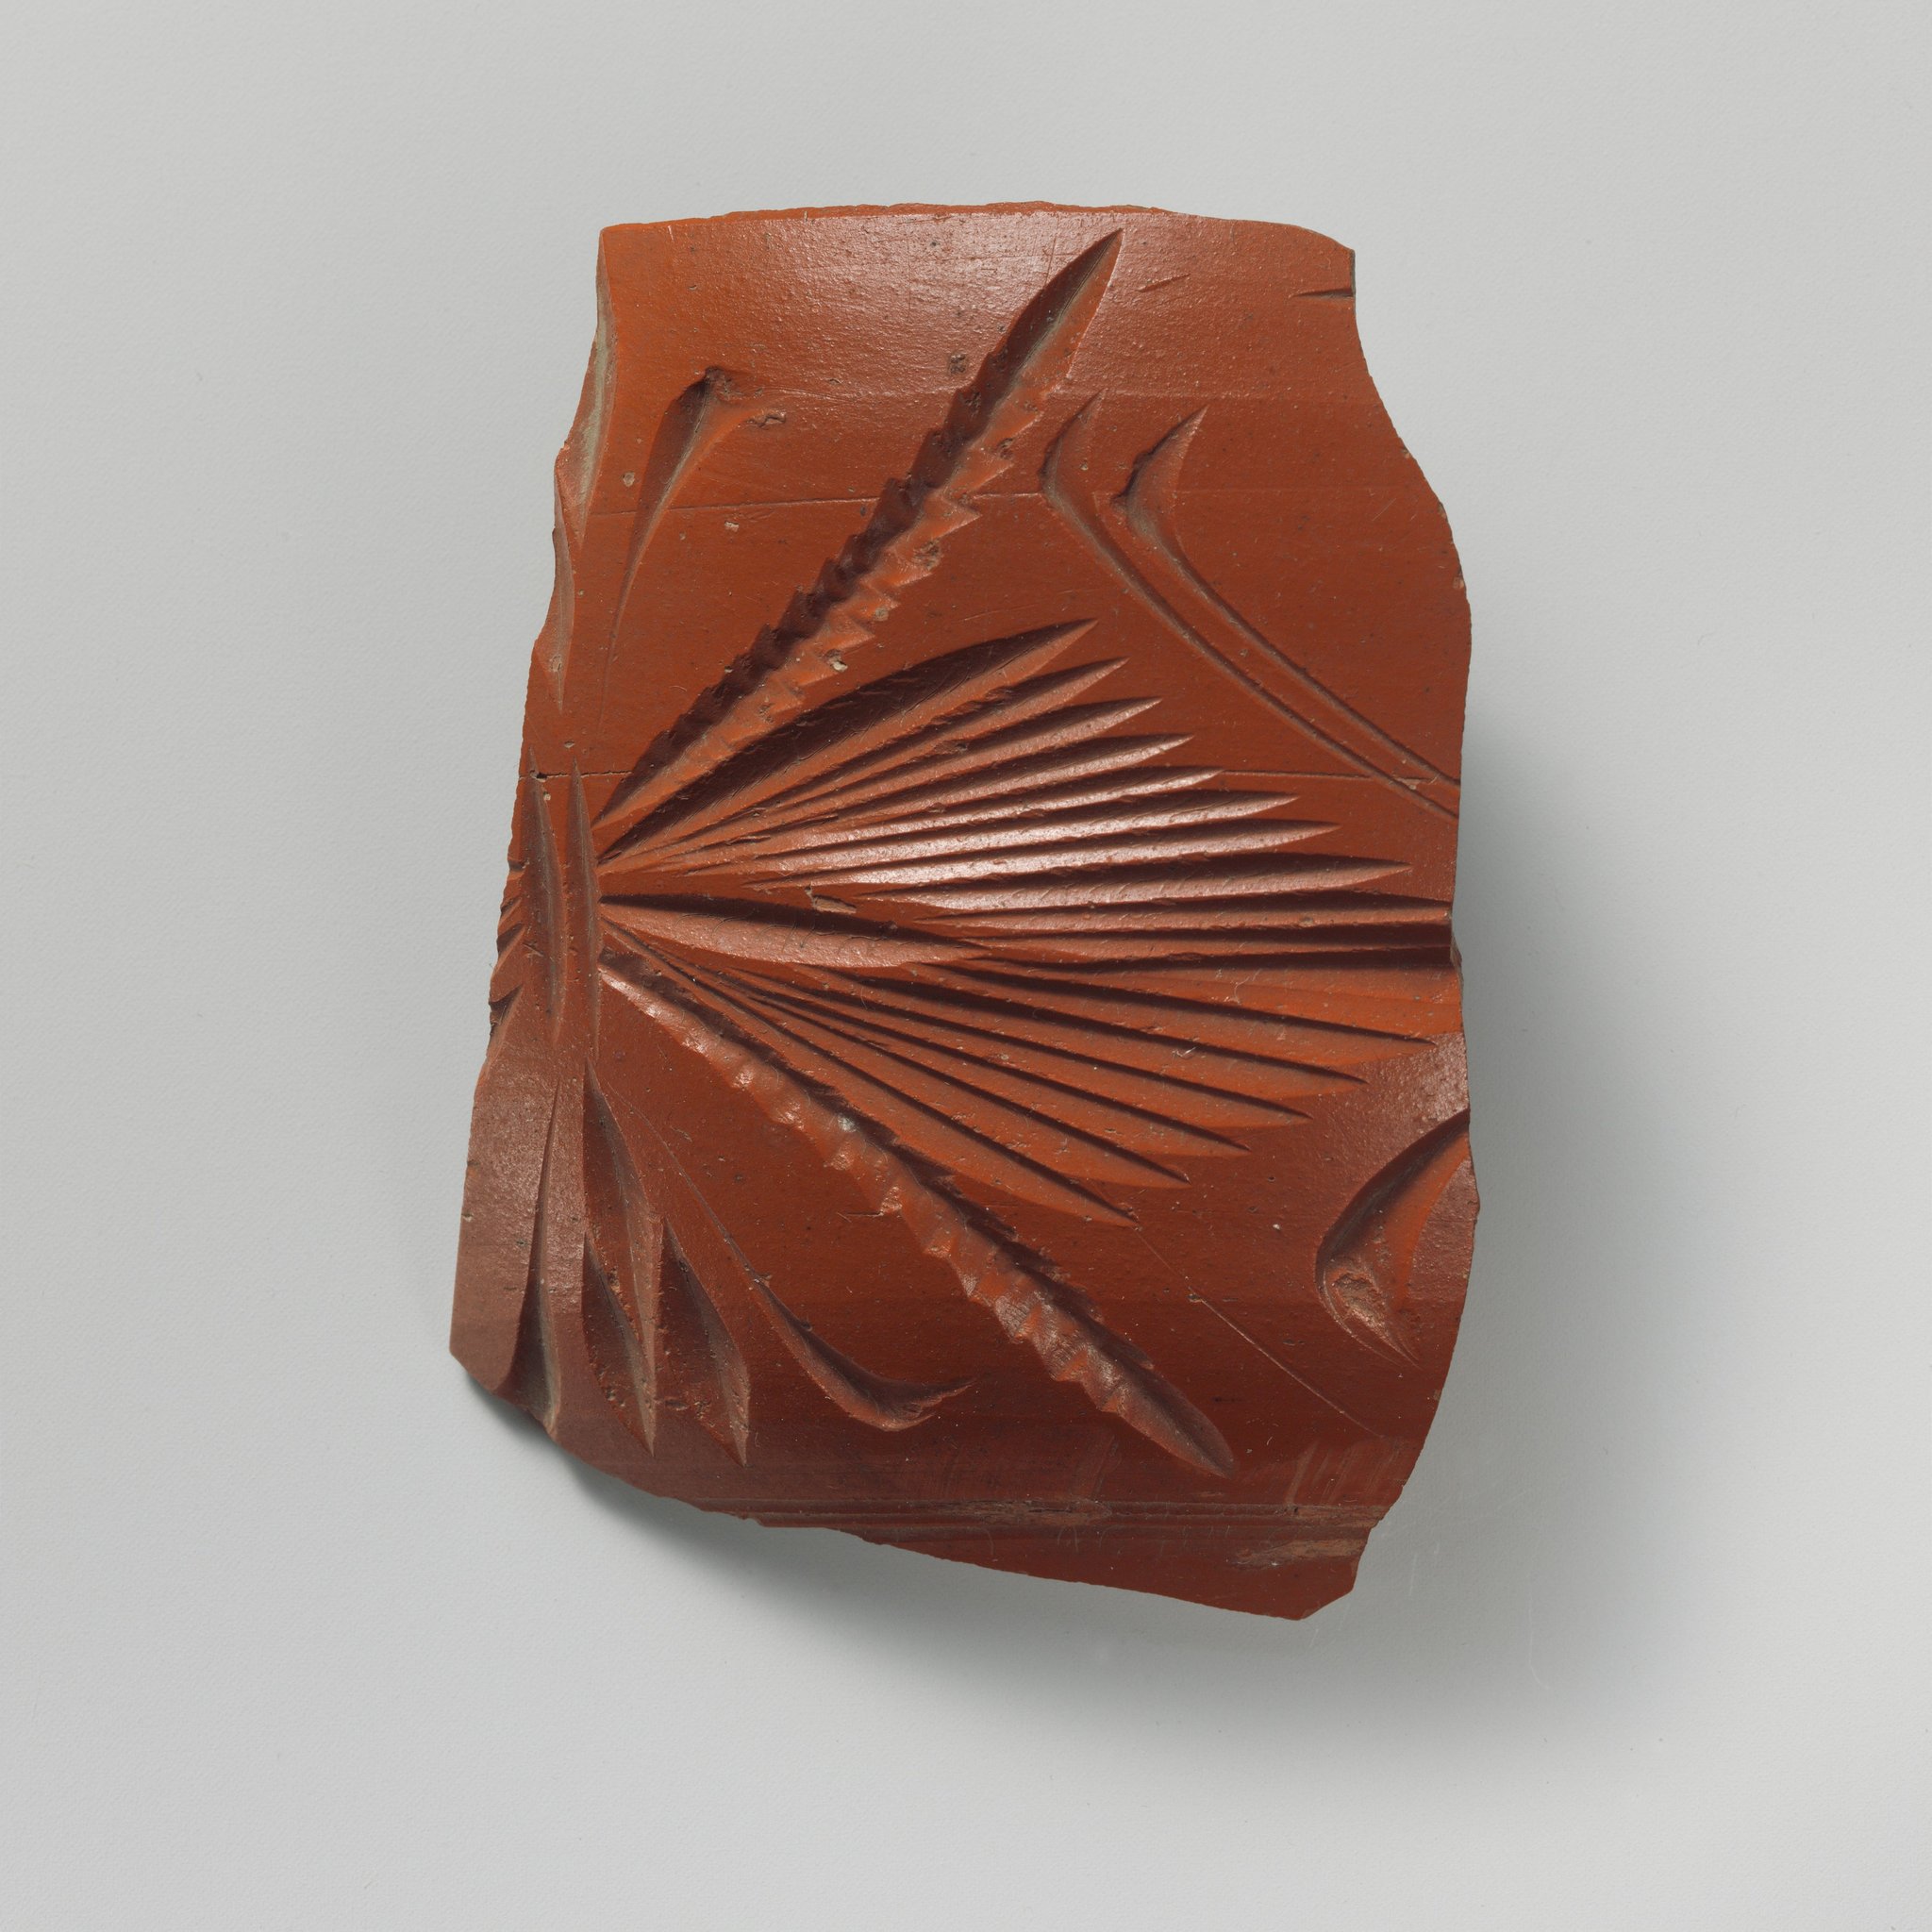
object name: vase fragment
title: Fragment of terra sigillata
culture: roman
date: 170-220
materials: terracotta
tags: leaves